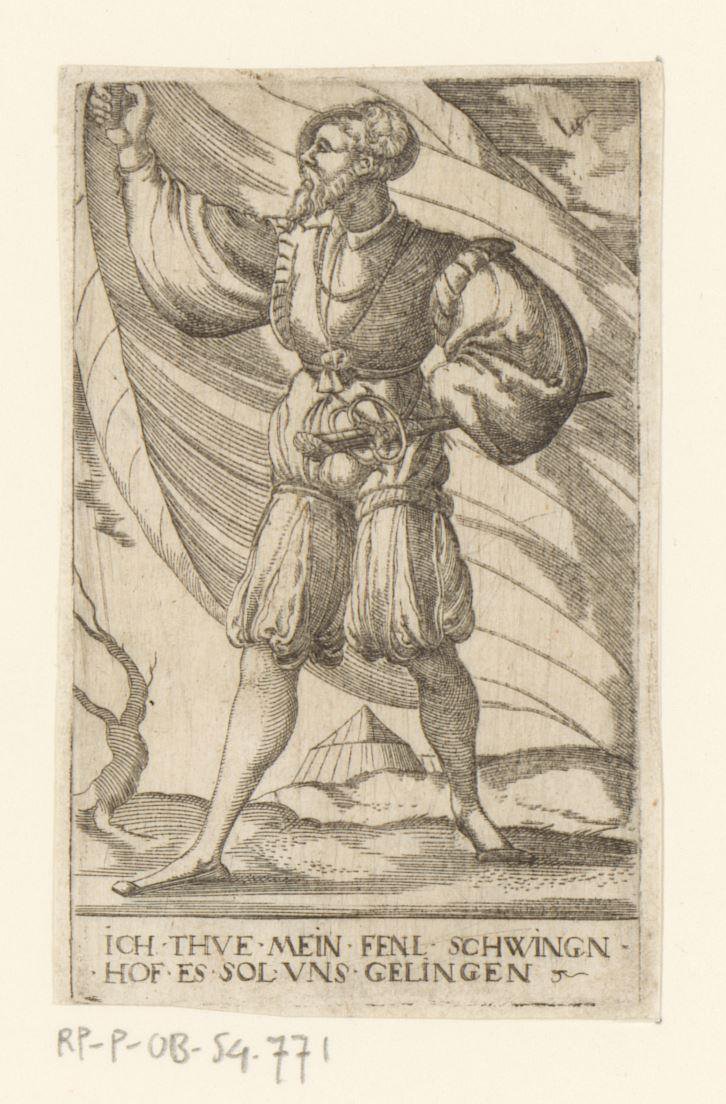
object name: print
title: Militaire figuren van verschillende rangen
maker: virgilius solis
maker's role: draughtsman, print maker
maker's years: 1514-1562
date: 1524-1562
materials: paper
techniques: engraving, etching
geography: nuremberg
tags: ranks in the army, (military) standard-bearer, the soldier; the soldier's life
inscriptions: collector's mark: Lugt 2228, number: ‘141’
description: Prent maakt deel uit van een serie bestaande uit twaalf prenten met militaire figuren van verschillende rangen.